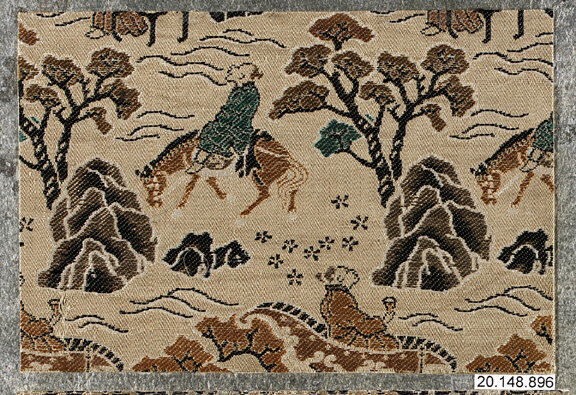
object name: textile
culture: china or japan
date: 1701-1800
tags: men,horses